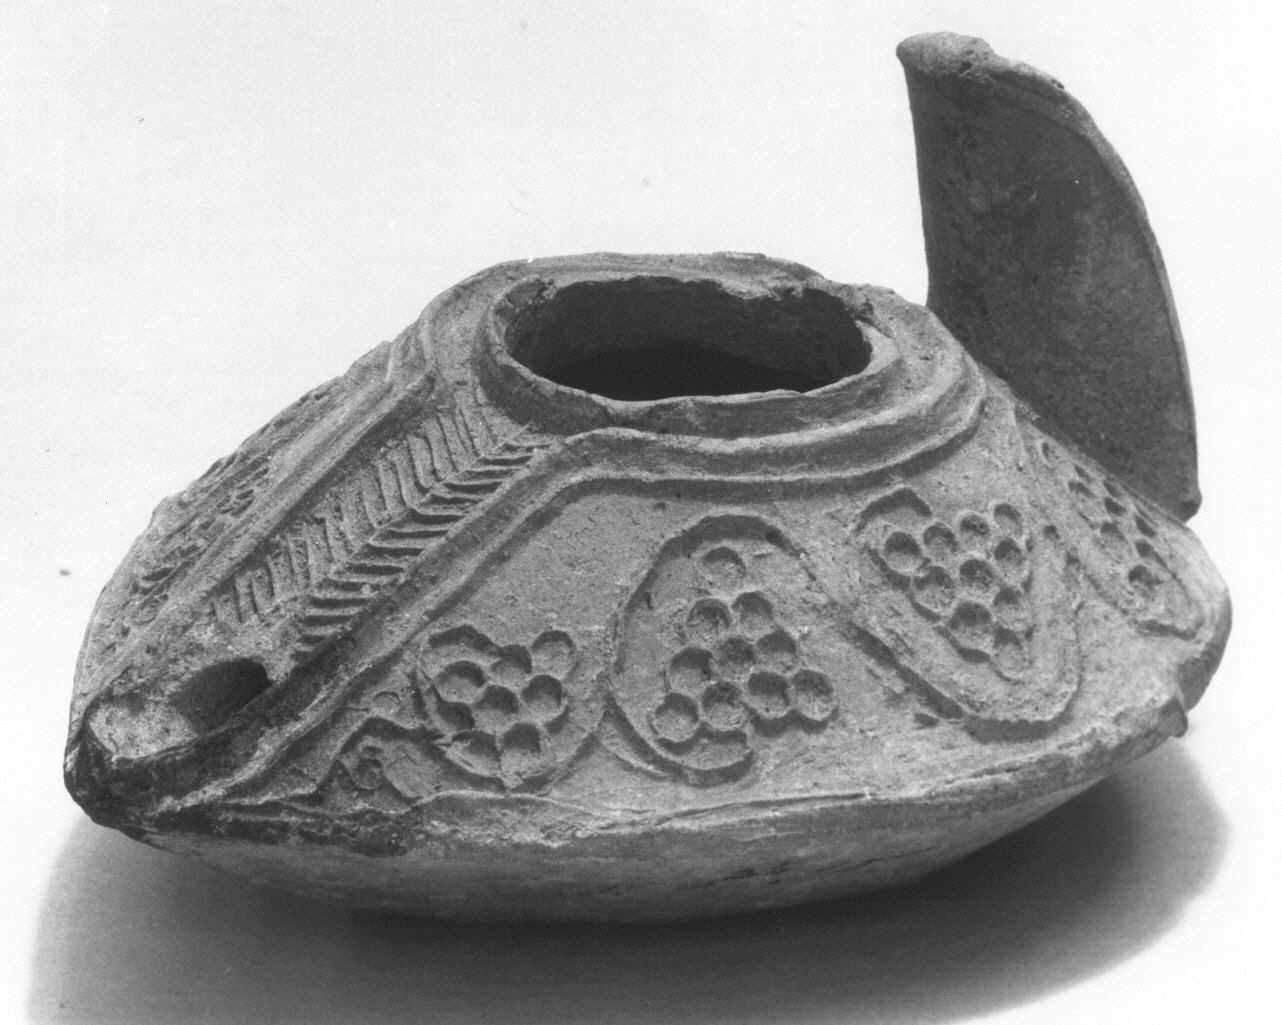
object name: lamp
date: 601-800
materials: earthenware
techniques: molding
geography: syria